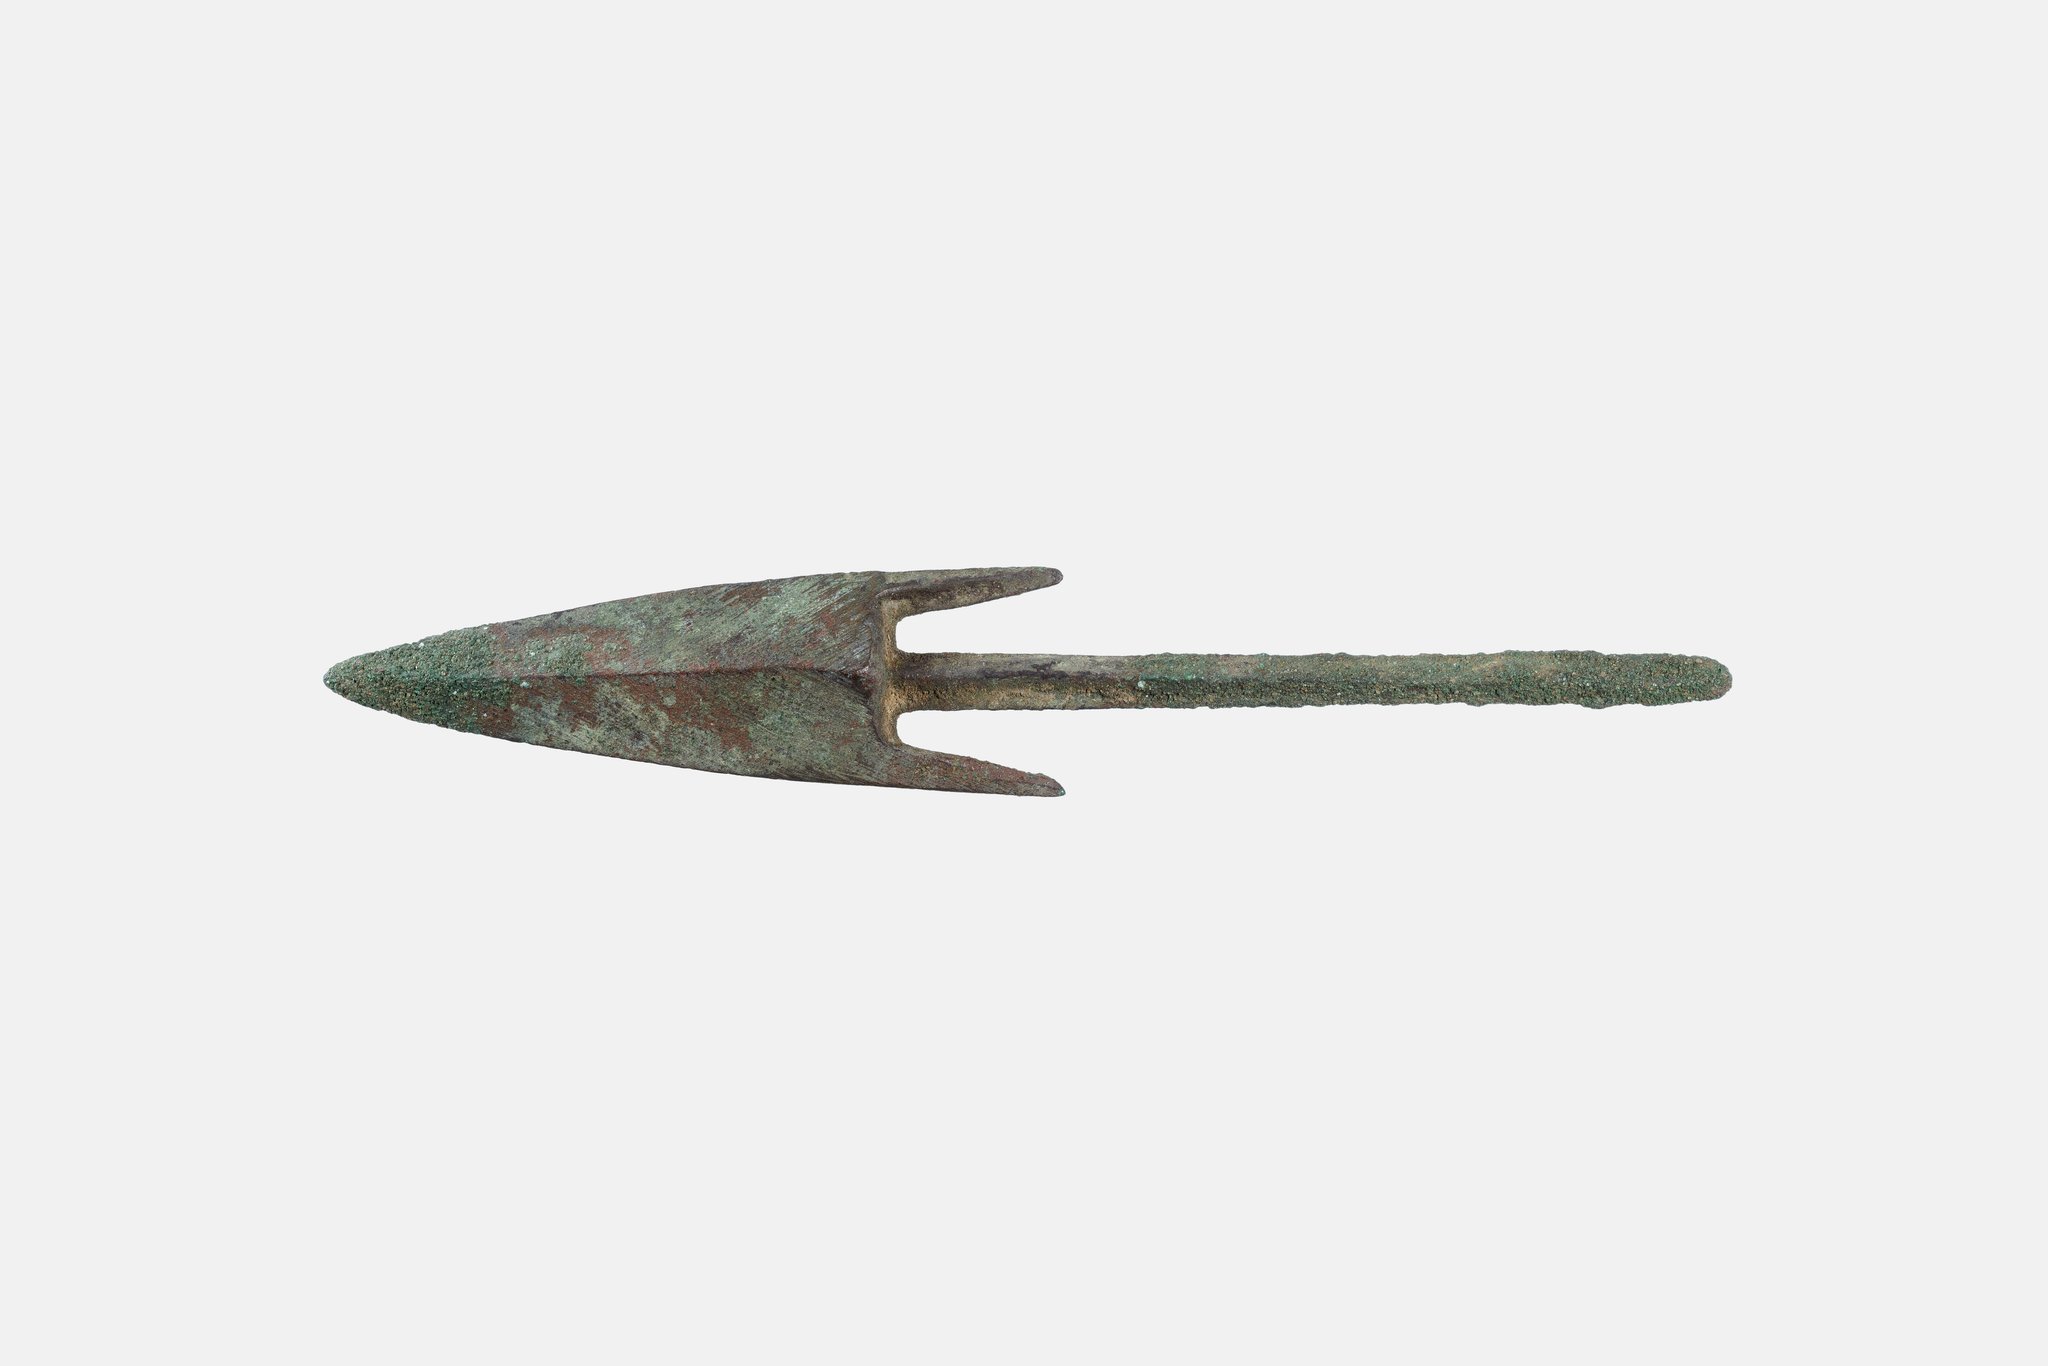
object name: arrowhead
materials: iron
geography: egypt